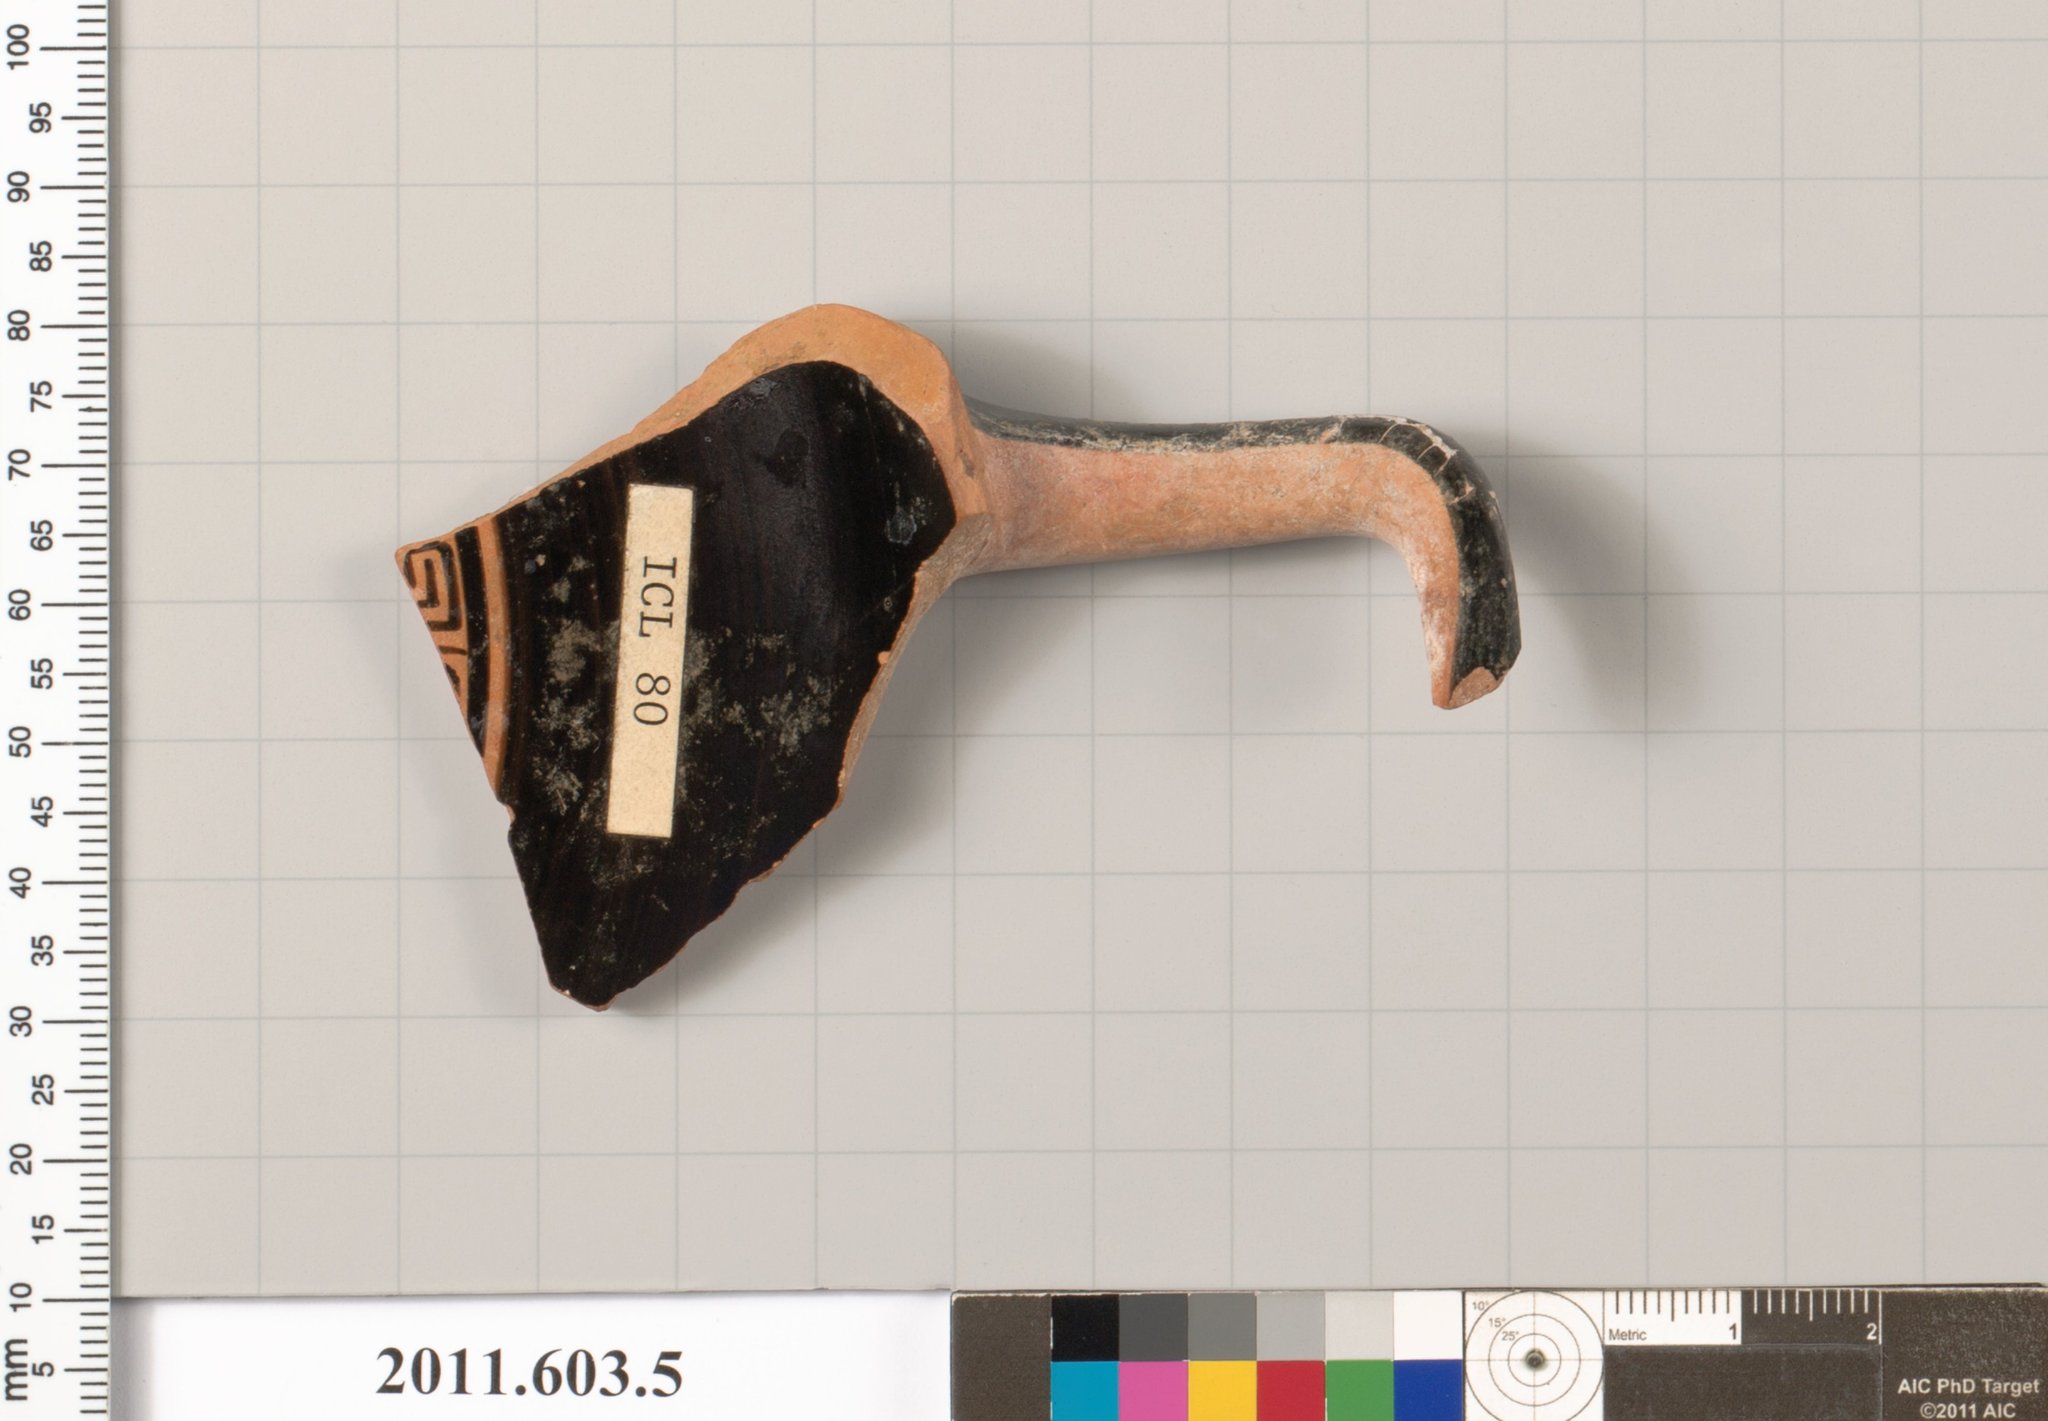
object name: kylix fragment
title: Fragment of a terracotta kylix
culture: greek, attic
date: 467-435 BCE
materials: terracotta